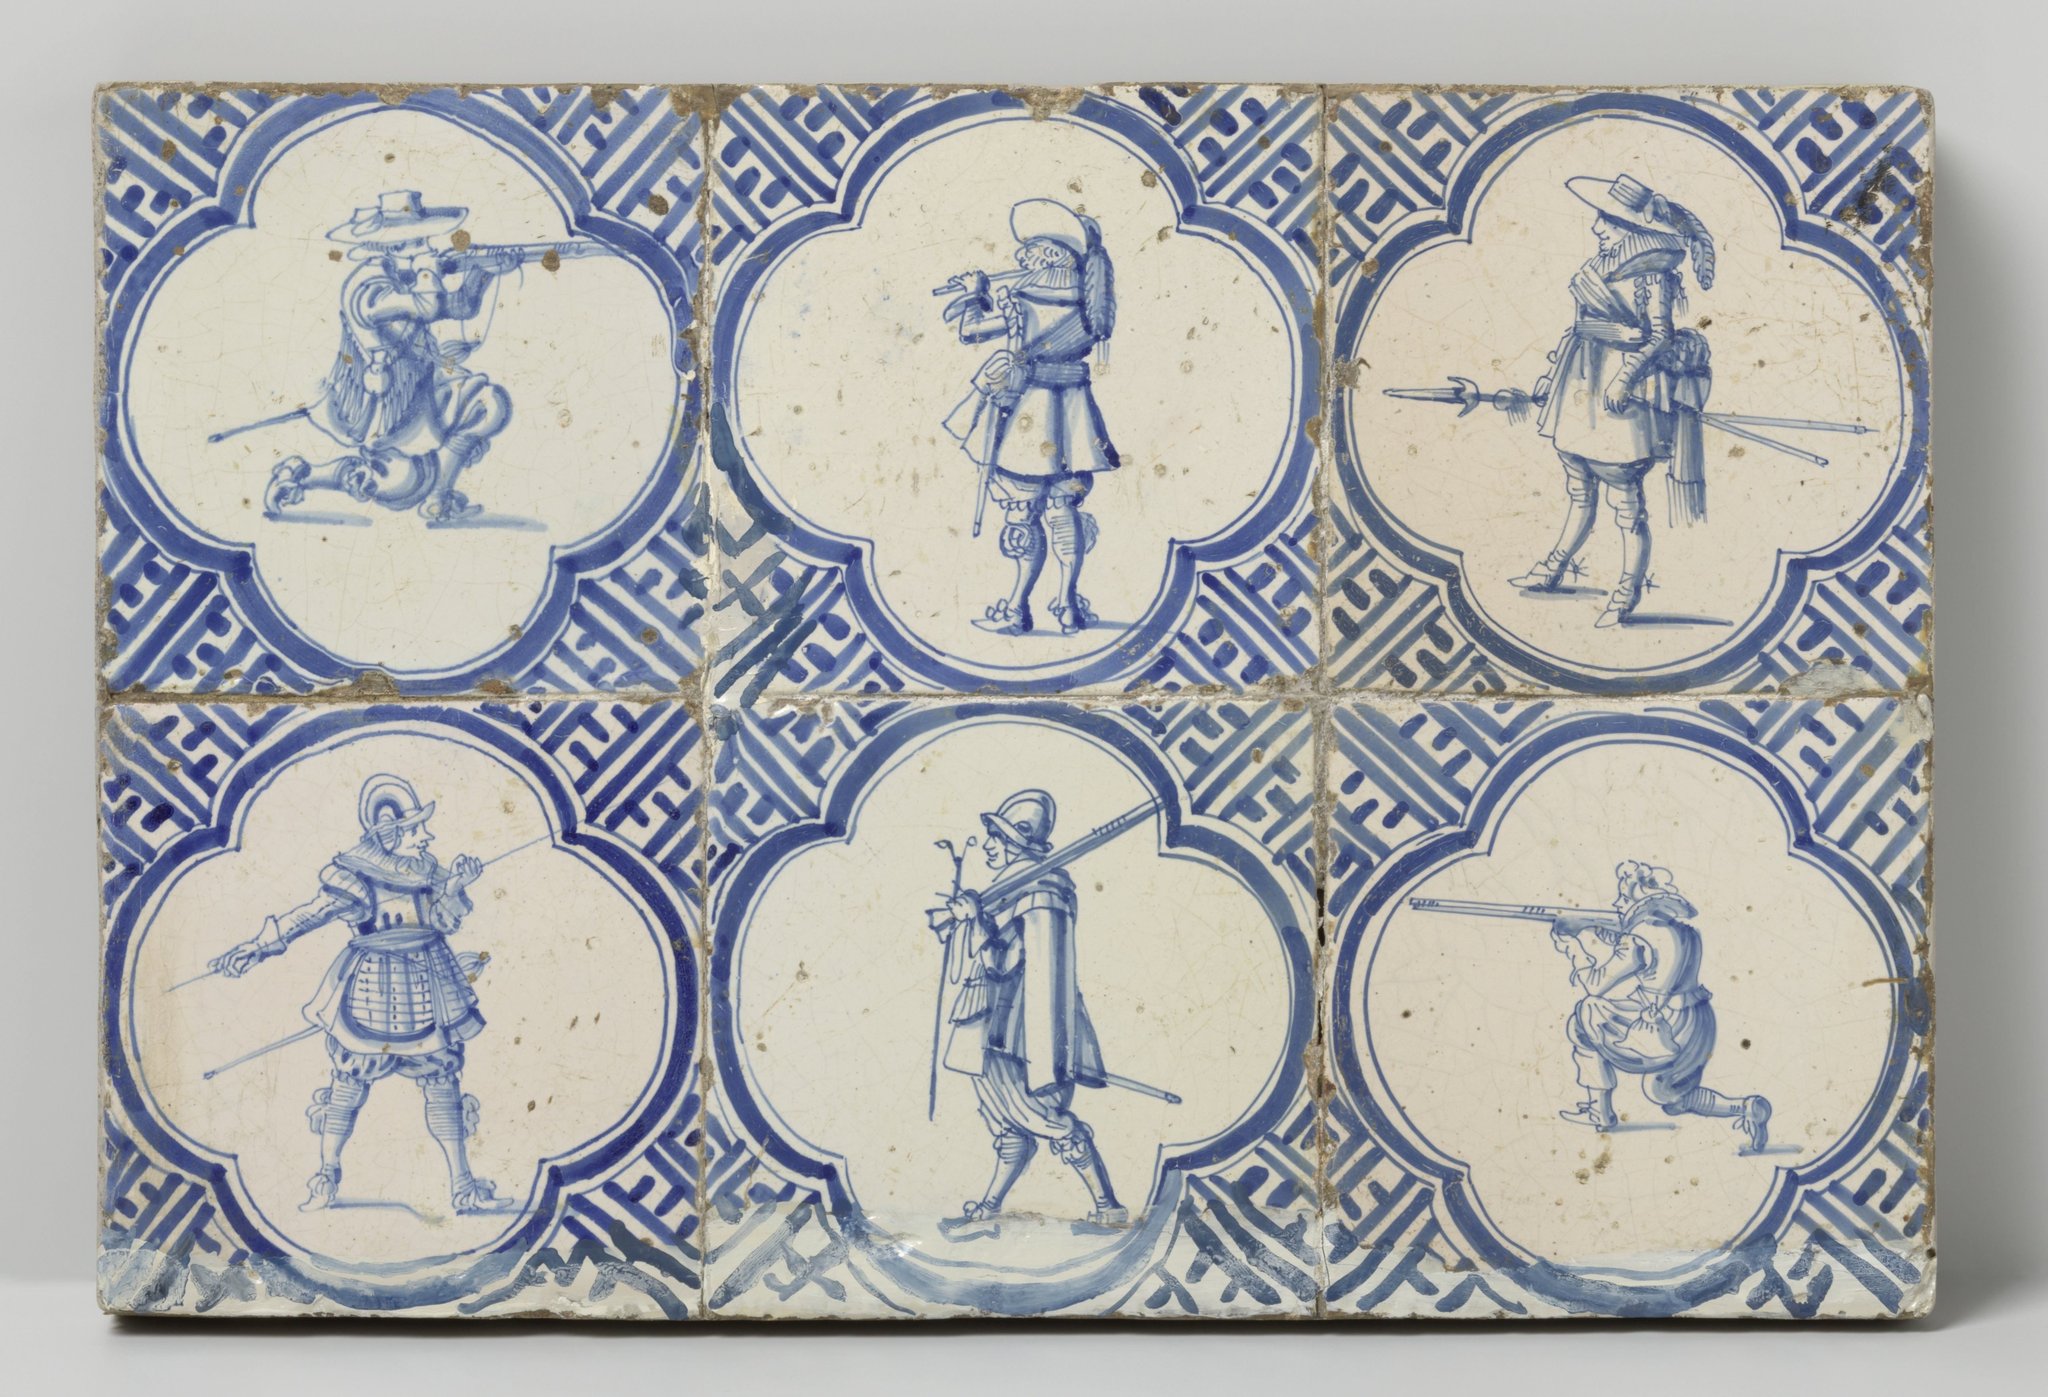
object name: tile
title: Veld van zes tegels met soldaten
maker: Anonymous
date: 1620-1640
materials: earthenware, glaze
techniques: maiolica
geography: netherlands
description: Veld van zes tegels (3 x 3) elk met een blauw geschilderde soldaat binnen een vierpas. In de hoeken, meander ornament.